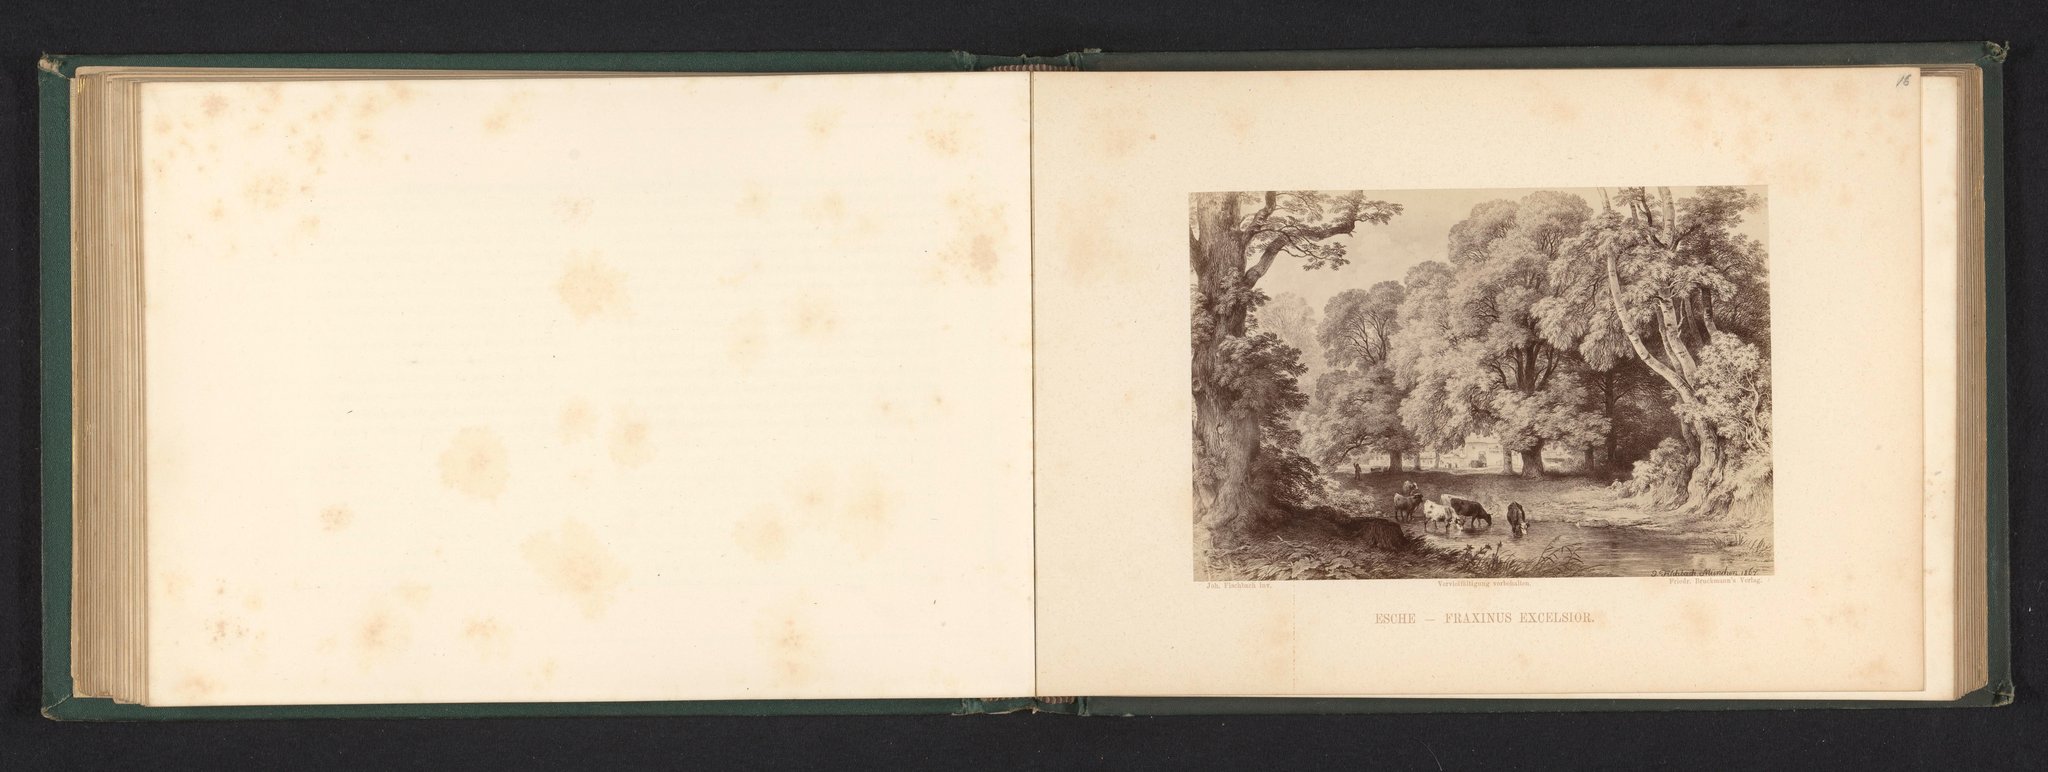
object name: reproduction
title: Esche - Graxinus Excelsior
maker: johann fischbach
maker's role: painter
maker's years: 1797-1871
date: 1867-1879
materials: photographic support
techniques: albumen print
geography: munich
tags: trees: ash-tree